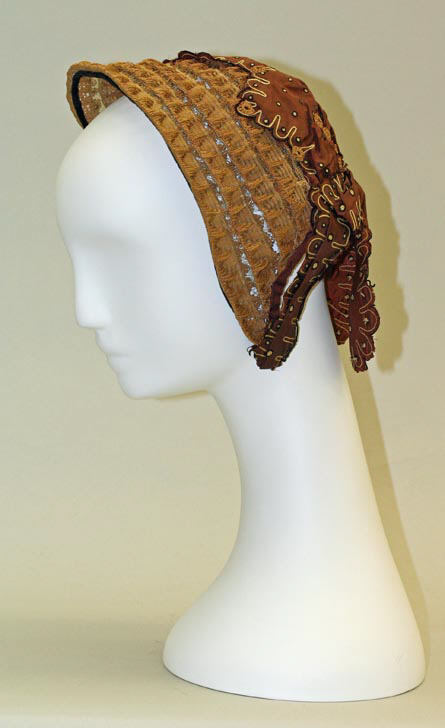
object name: promenade bonnet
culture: american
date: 1866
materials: silk, fiber